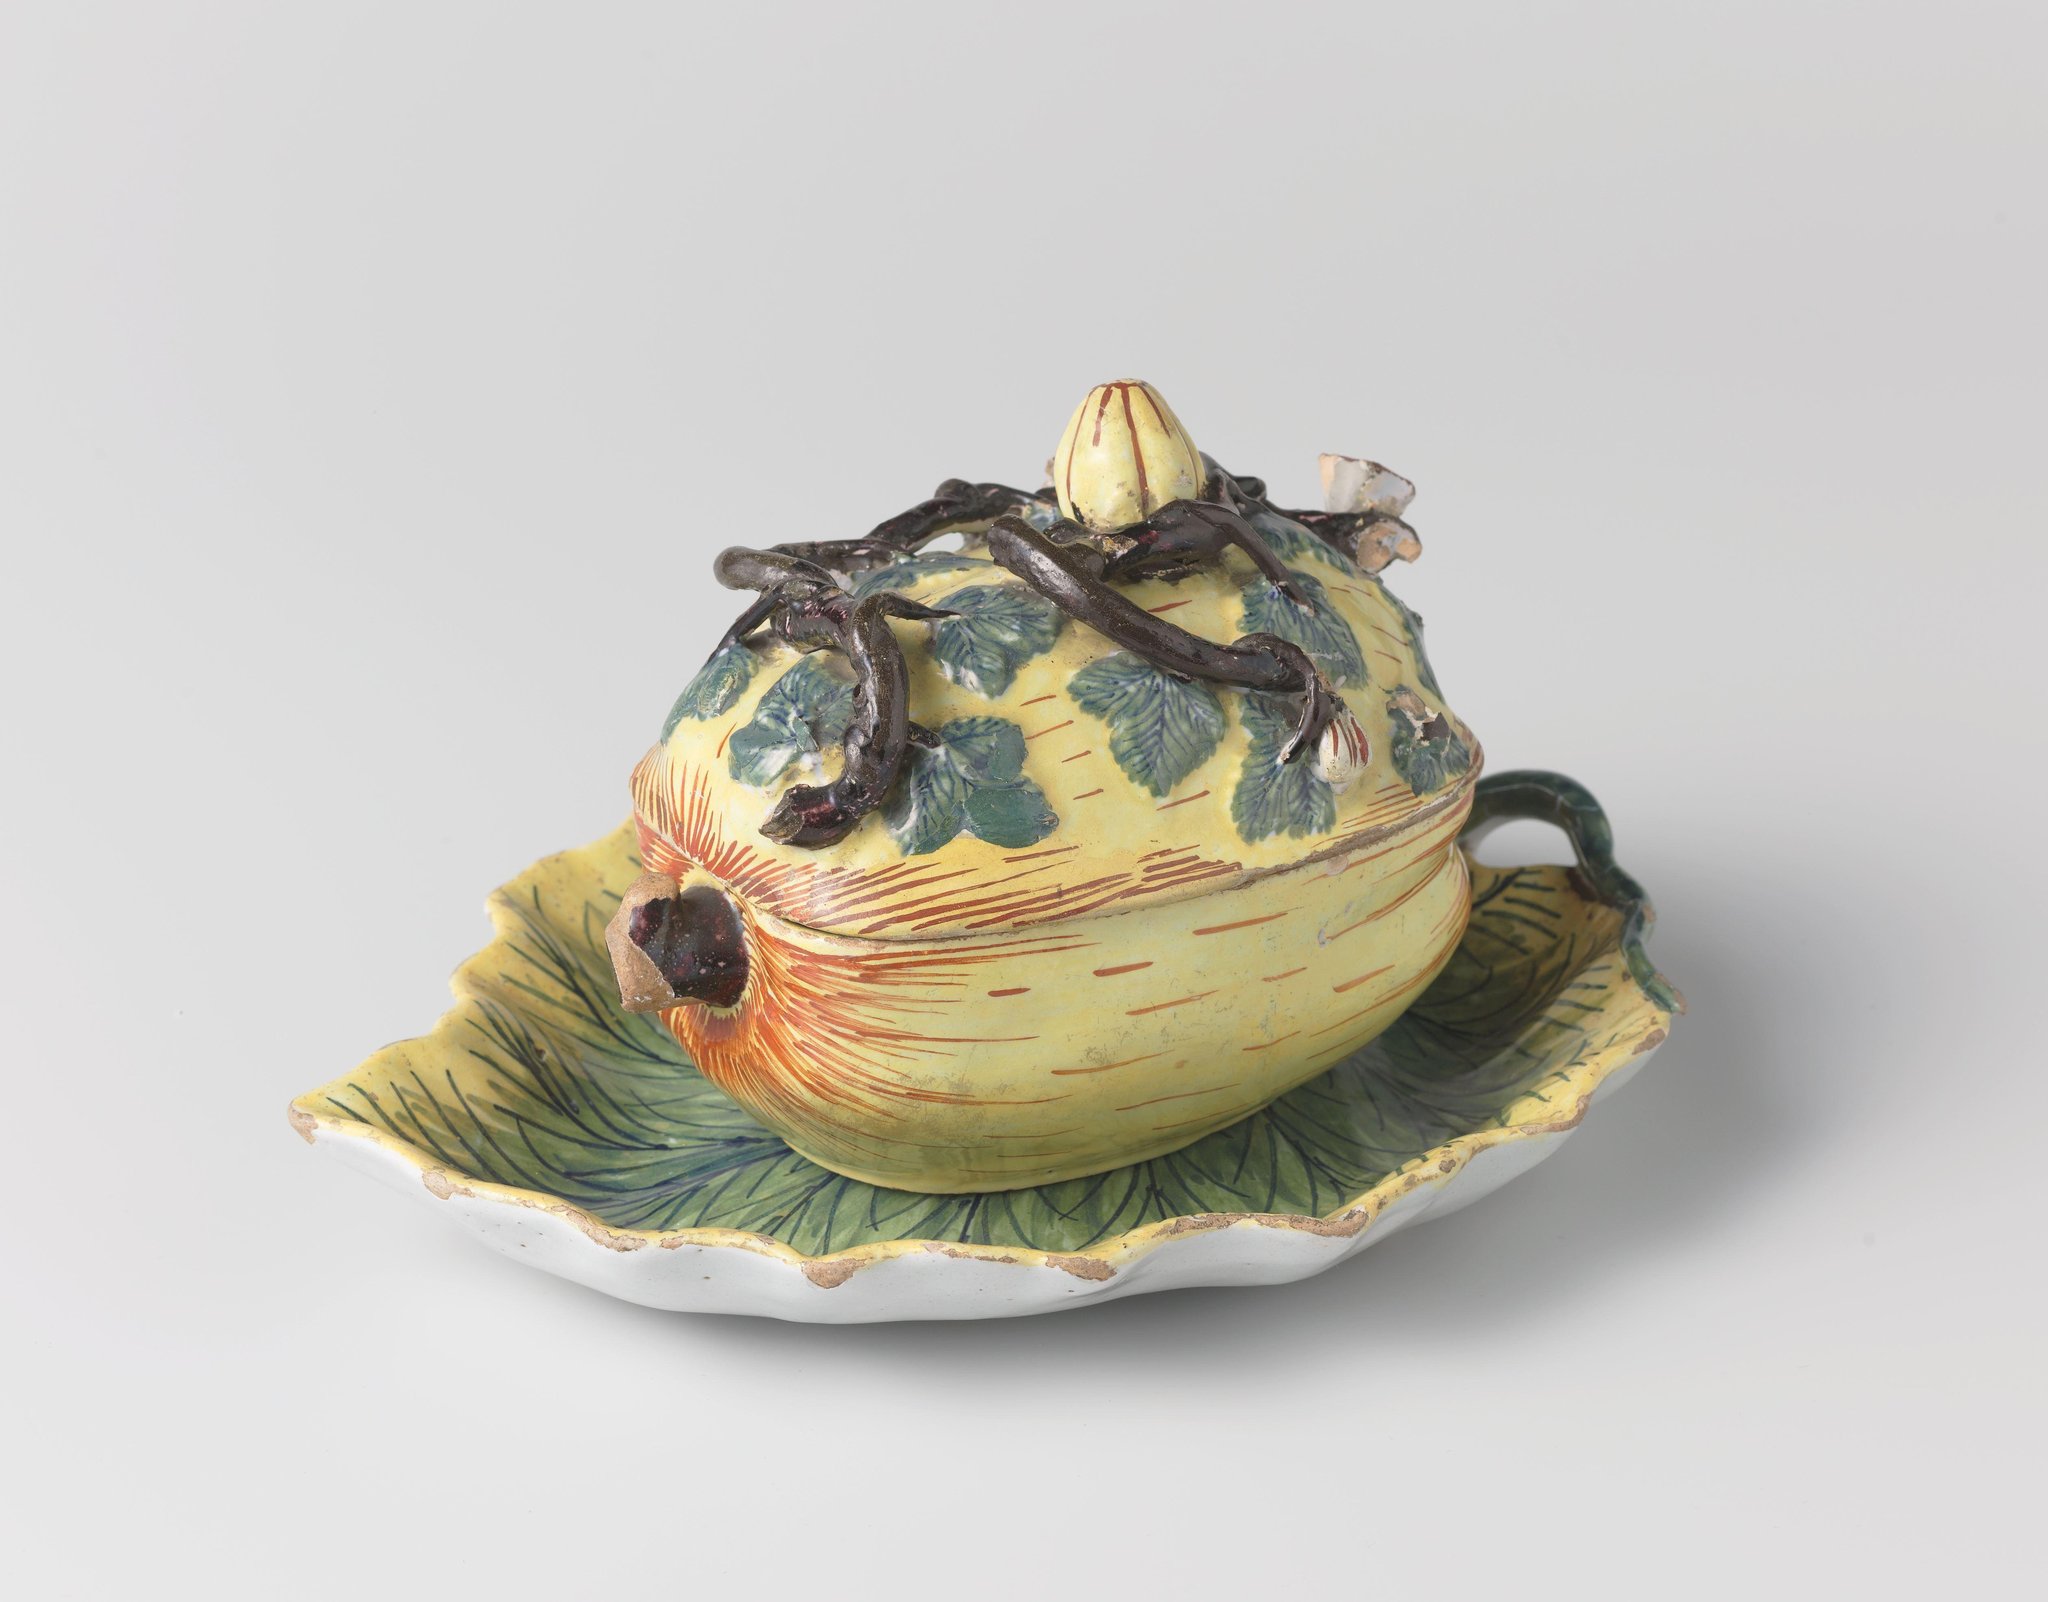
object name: platter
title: Terrine met deksel van veelkleurig beschilderde faience, in de vorm van een pompoen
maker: hendrik van hoorn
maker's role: eigenaar plateelbakkerij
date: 1759-1804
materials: faience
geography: delft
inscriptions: mark: ‘19’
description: Terrine van faience in de vorm van een pompoen. Veelkleurig beschilderd. Gemerkt: v H 3. Met bijbehorende onderschotel in de vorm van een blad.